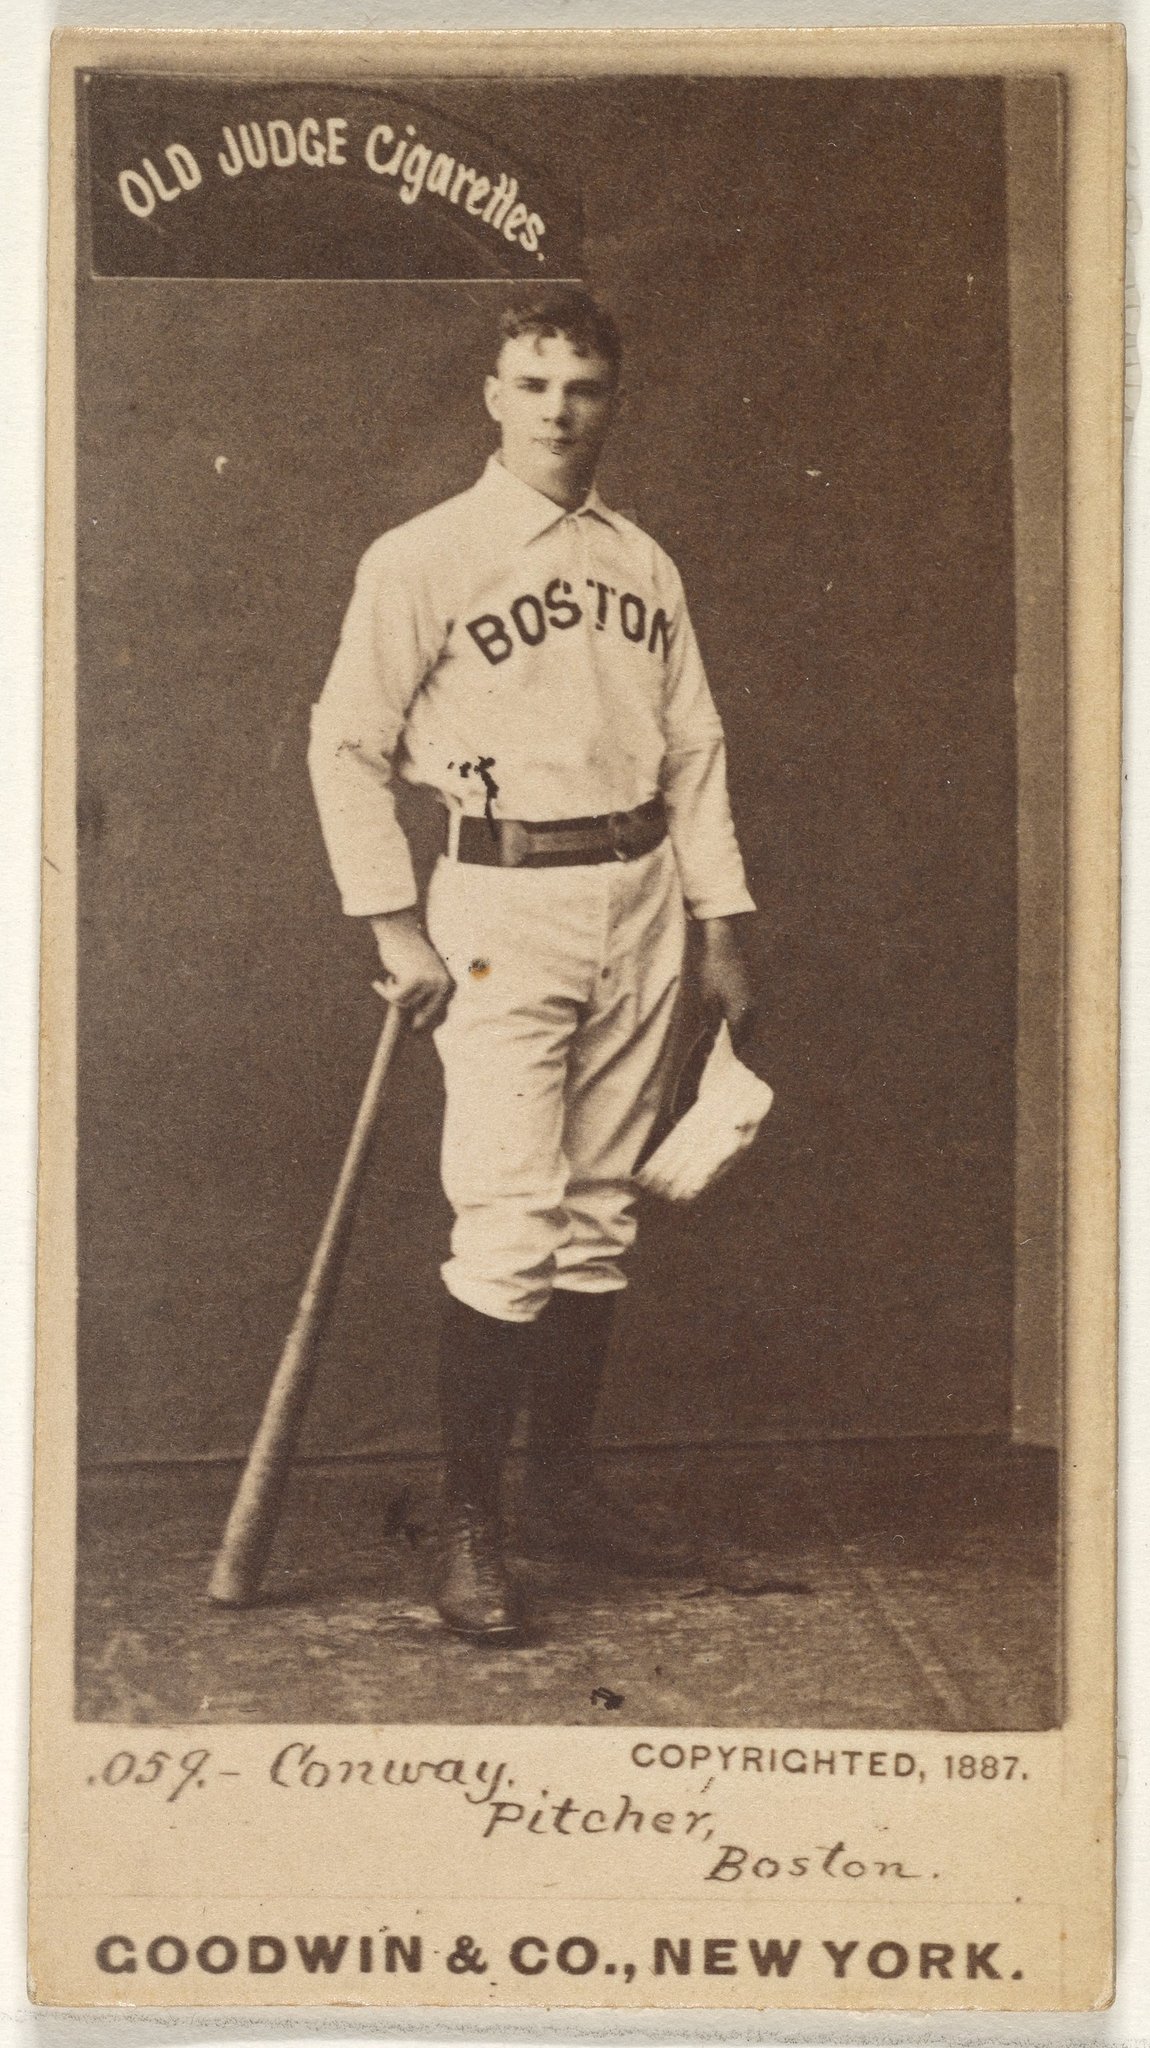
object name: baseball card, photograph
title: Conway, Pitcher, Boston, from the Old Judge series (N172) for Old Judge Cigarettes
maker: goodwin & company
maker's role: publisher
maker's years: 1850-1950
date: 1887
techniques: albumen silver print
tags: men,portraits,baseball,athletes